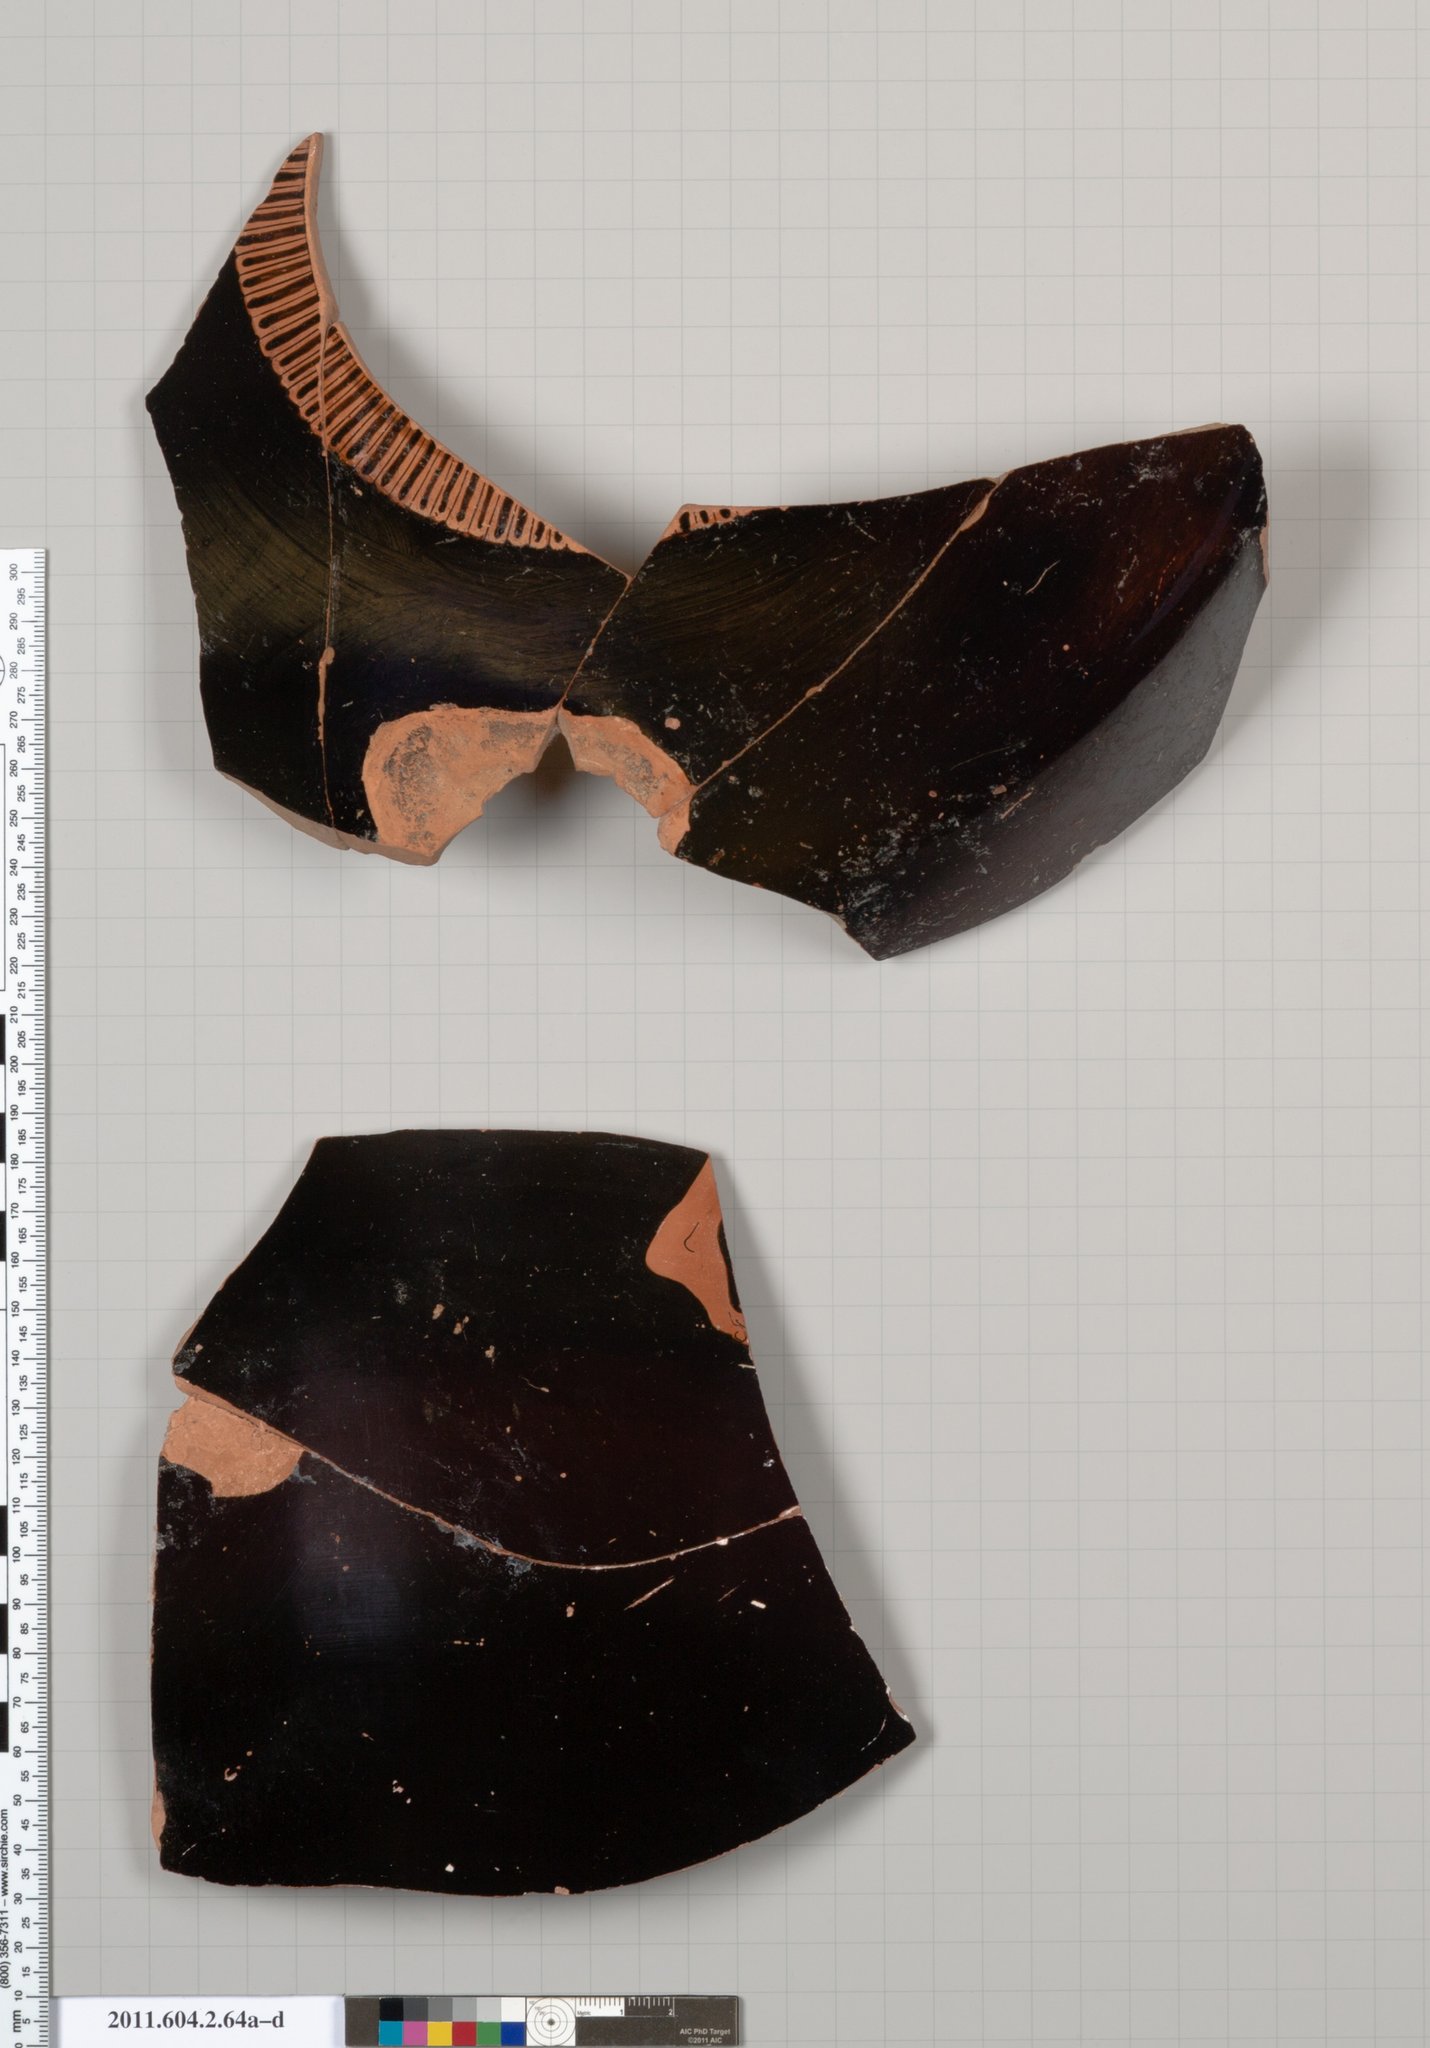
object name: amphora fragment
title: Terracotta fragments of an amphora (jar)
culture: greek, attic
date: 534-468 BCE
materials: terracotta